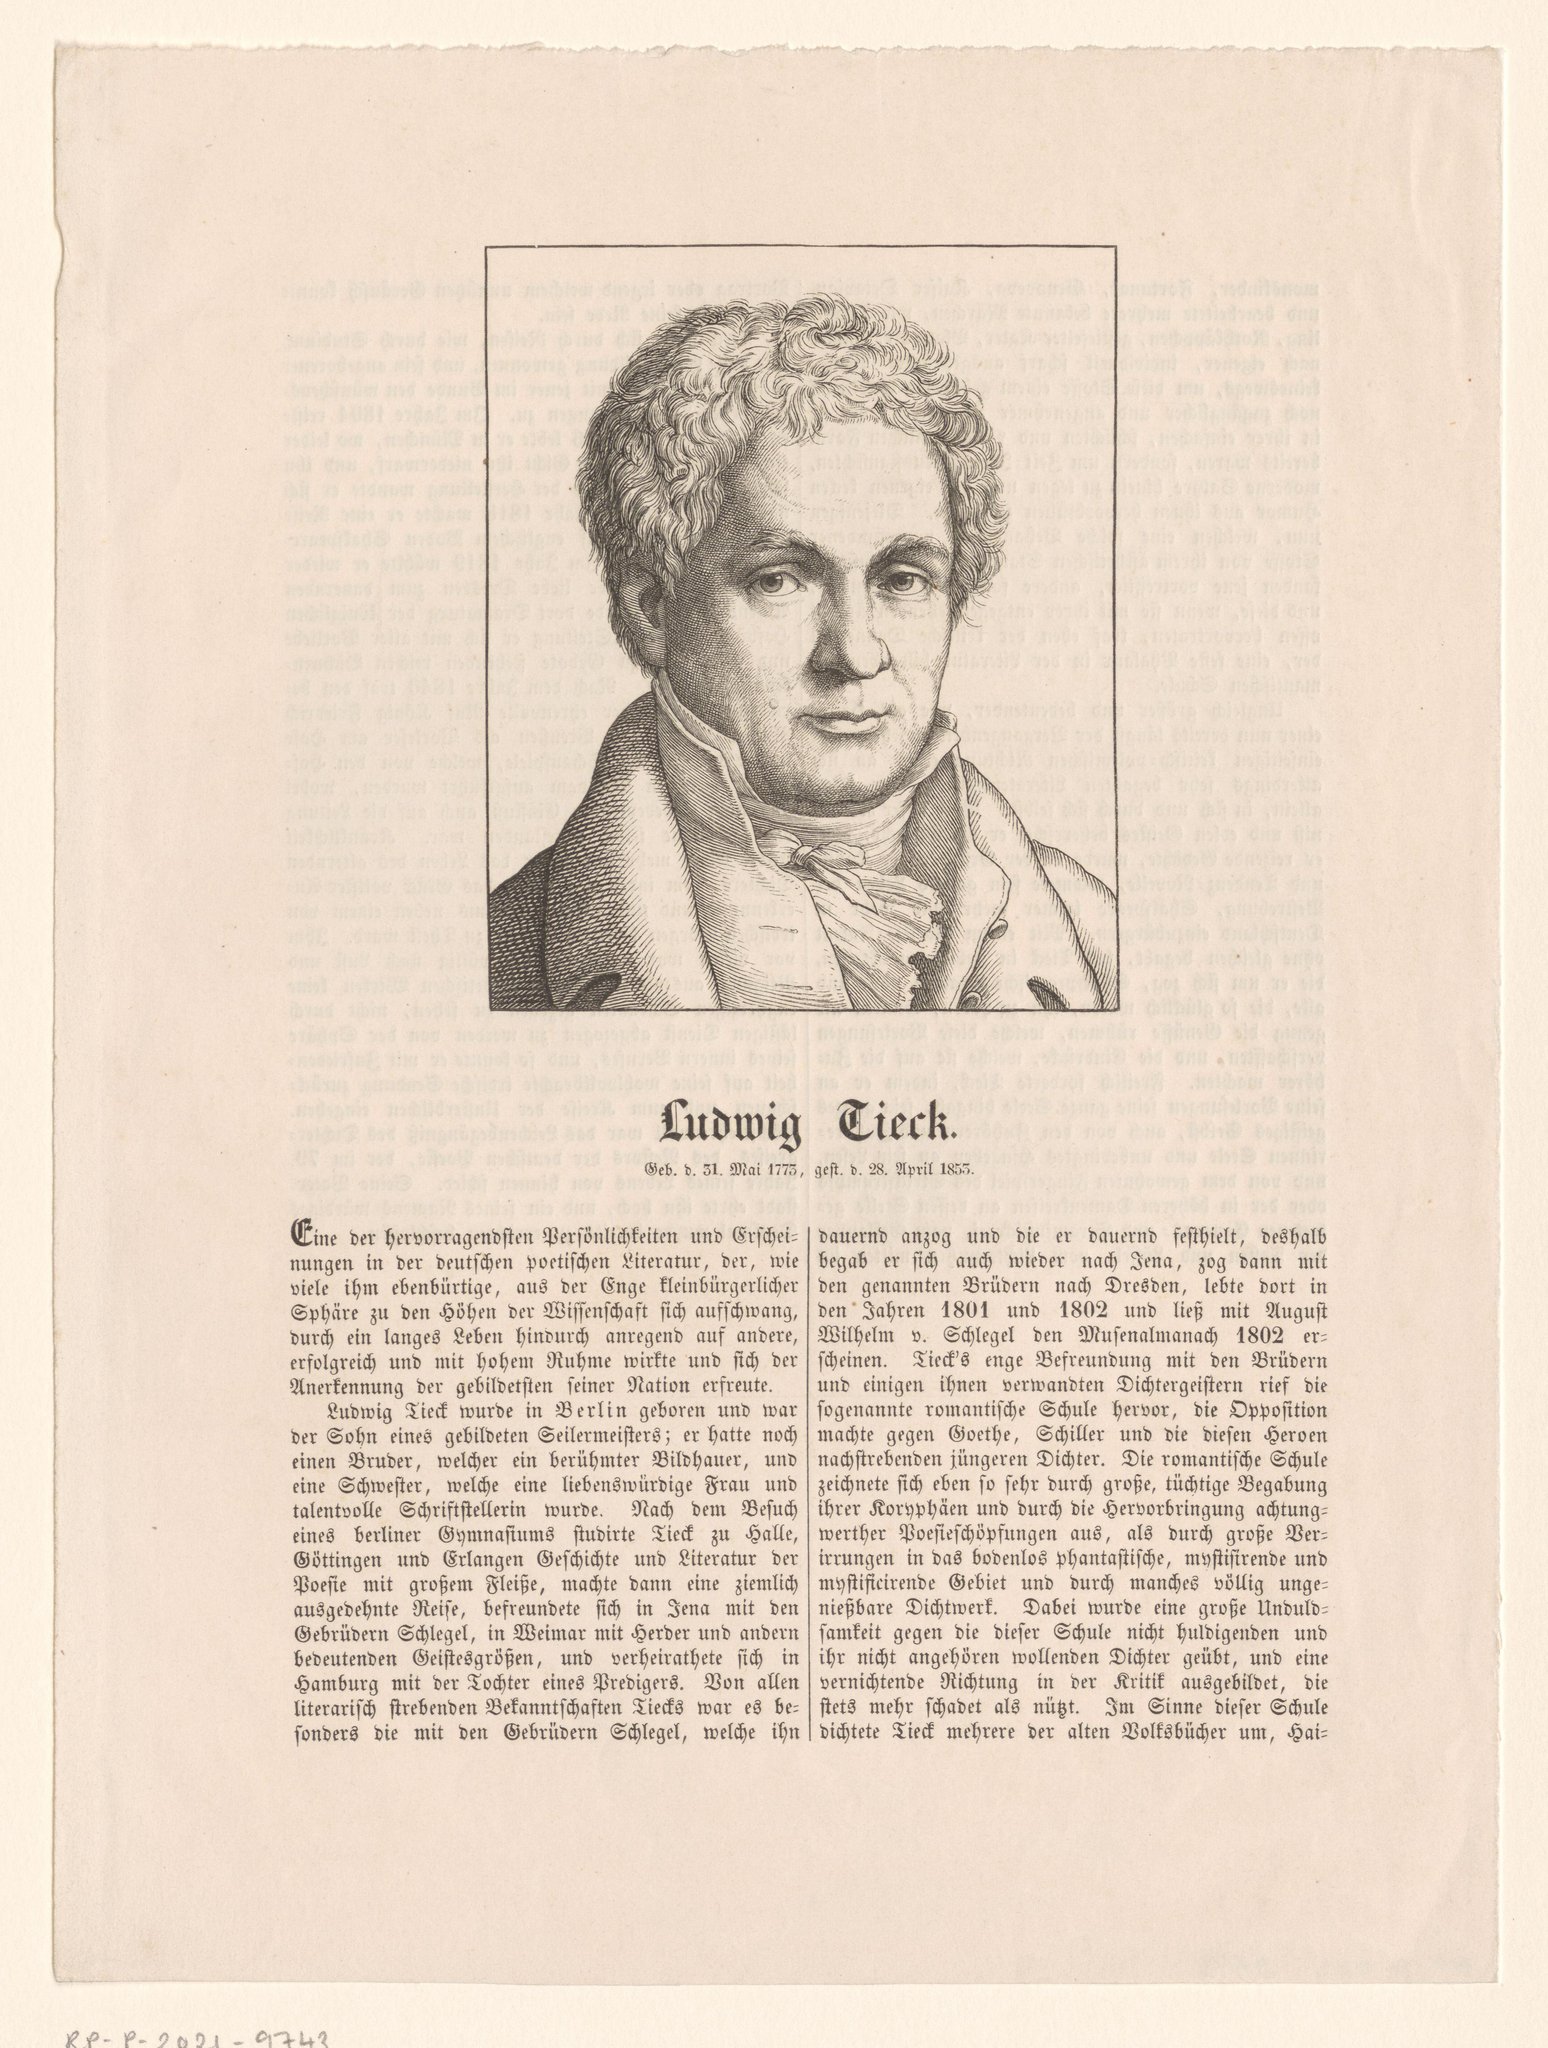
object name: print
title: Portret van Ludwig Tieck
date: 1854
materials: paper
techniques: letterpress printing, engraving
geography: leipzig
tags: berlin, historical persons, portrait of a writer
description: Prent uit: Bechstein, Ludwig. Zweihundert deutsche Männer in Bildnissen und Lebensbeschreibungen. Leipzig: Georg Wigand, 1854.